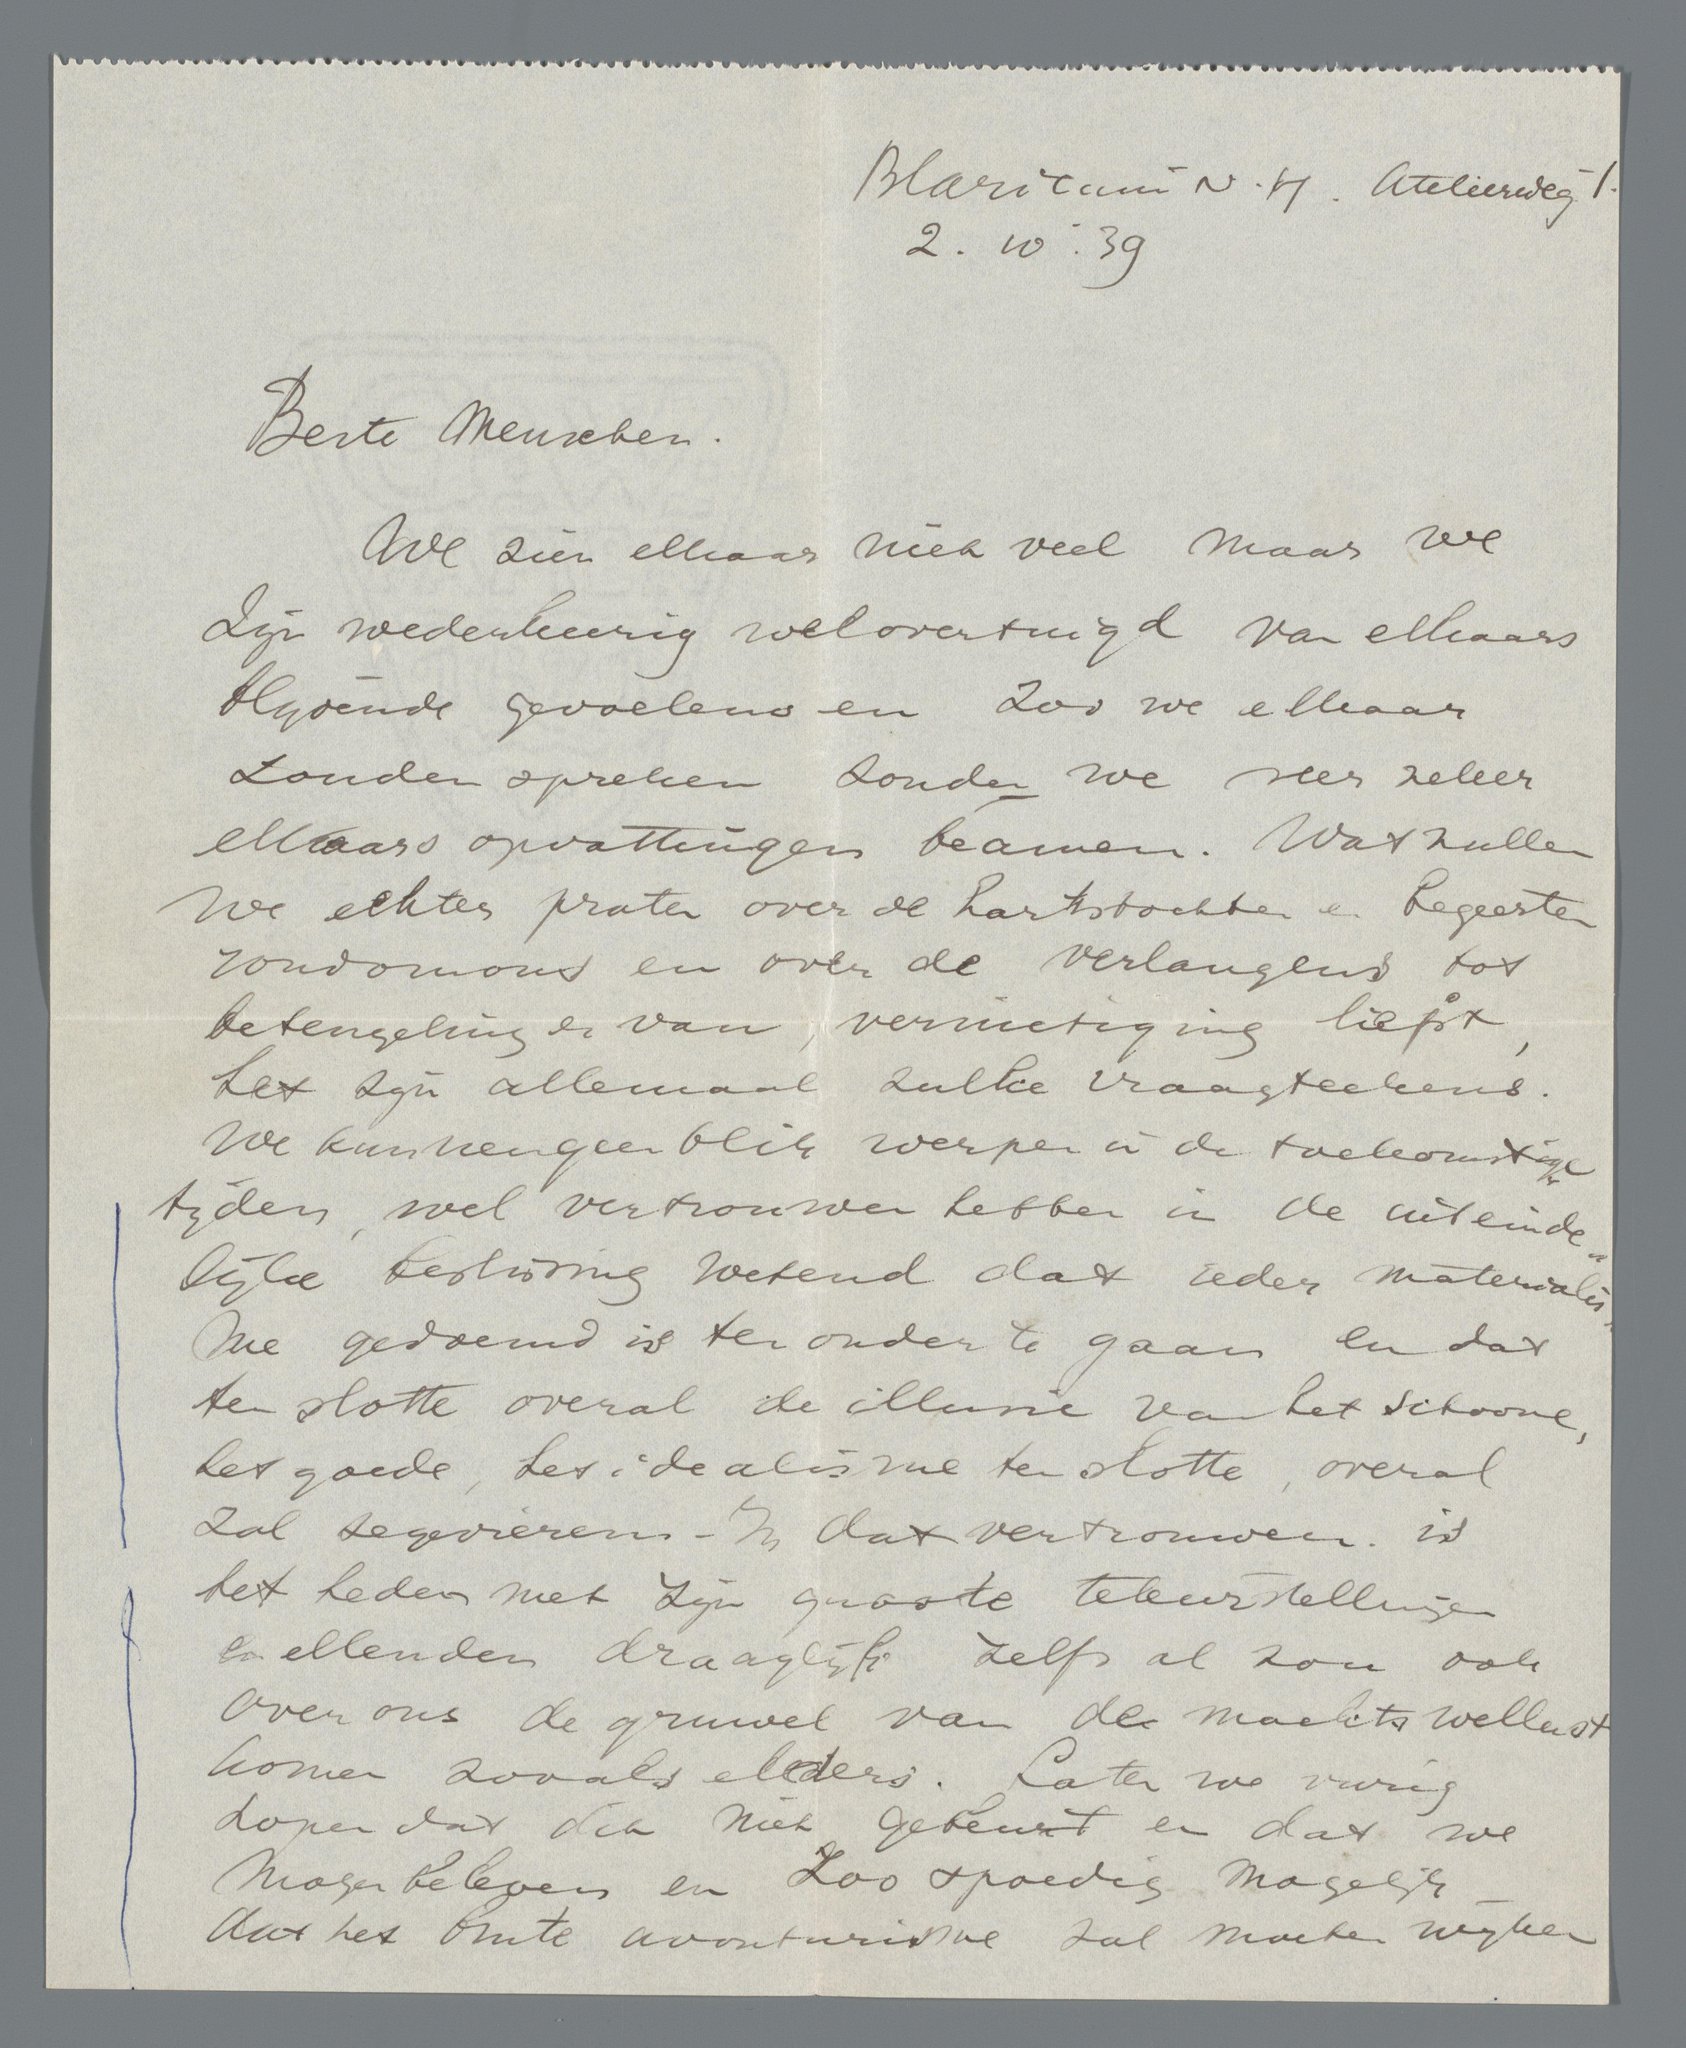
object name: letter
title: Brief aan Jan Ponstijn en Henriëtte Johanna Petronella van Hilten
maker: leo gestel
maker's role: draughtsman, print maker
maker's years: 1881-1941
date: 1939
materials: ink, paper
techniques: pen, writing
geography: blaricum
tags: henriëtte johanna petronella ponstijn-van hilten, amsterdam, jan petrus ponstijn, mommie schwarz, matthieu wiegman, painter, gerritje gestel-overtoom, birthday, war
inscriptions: date